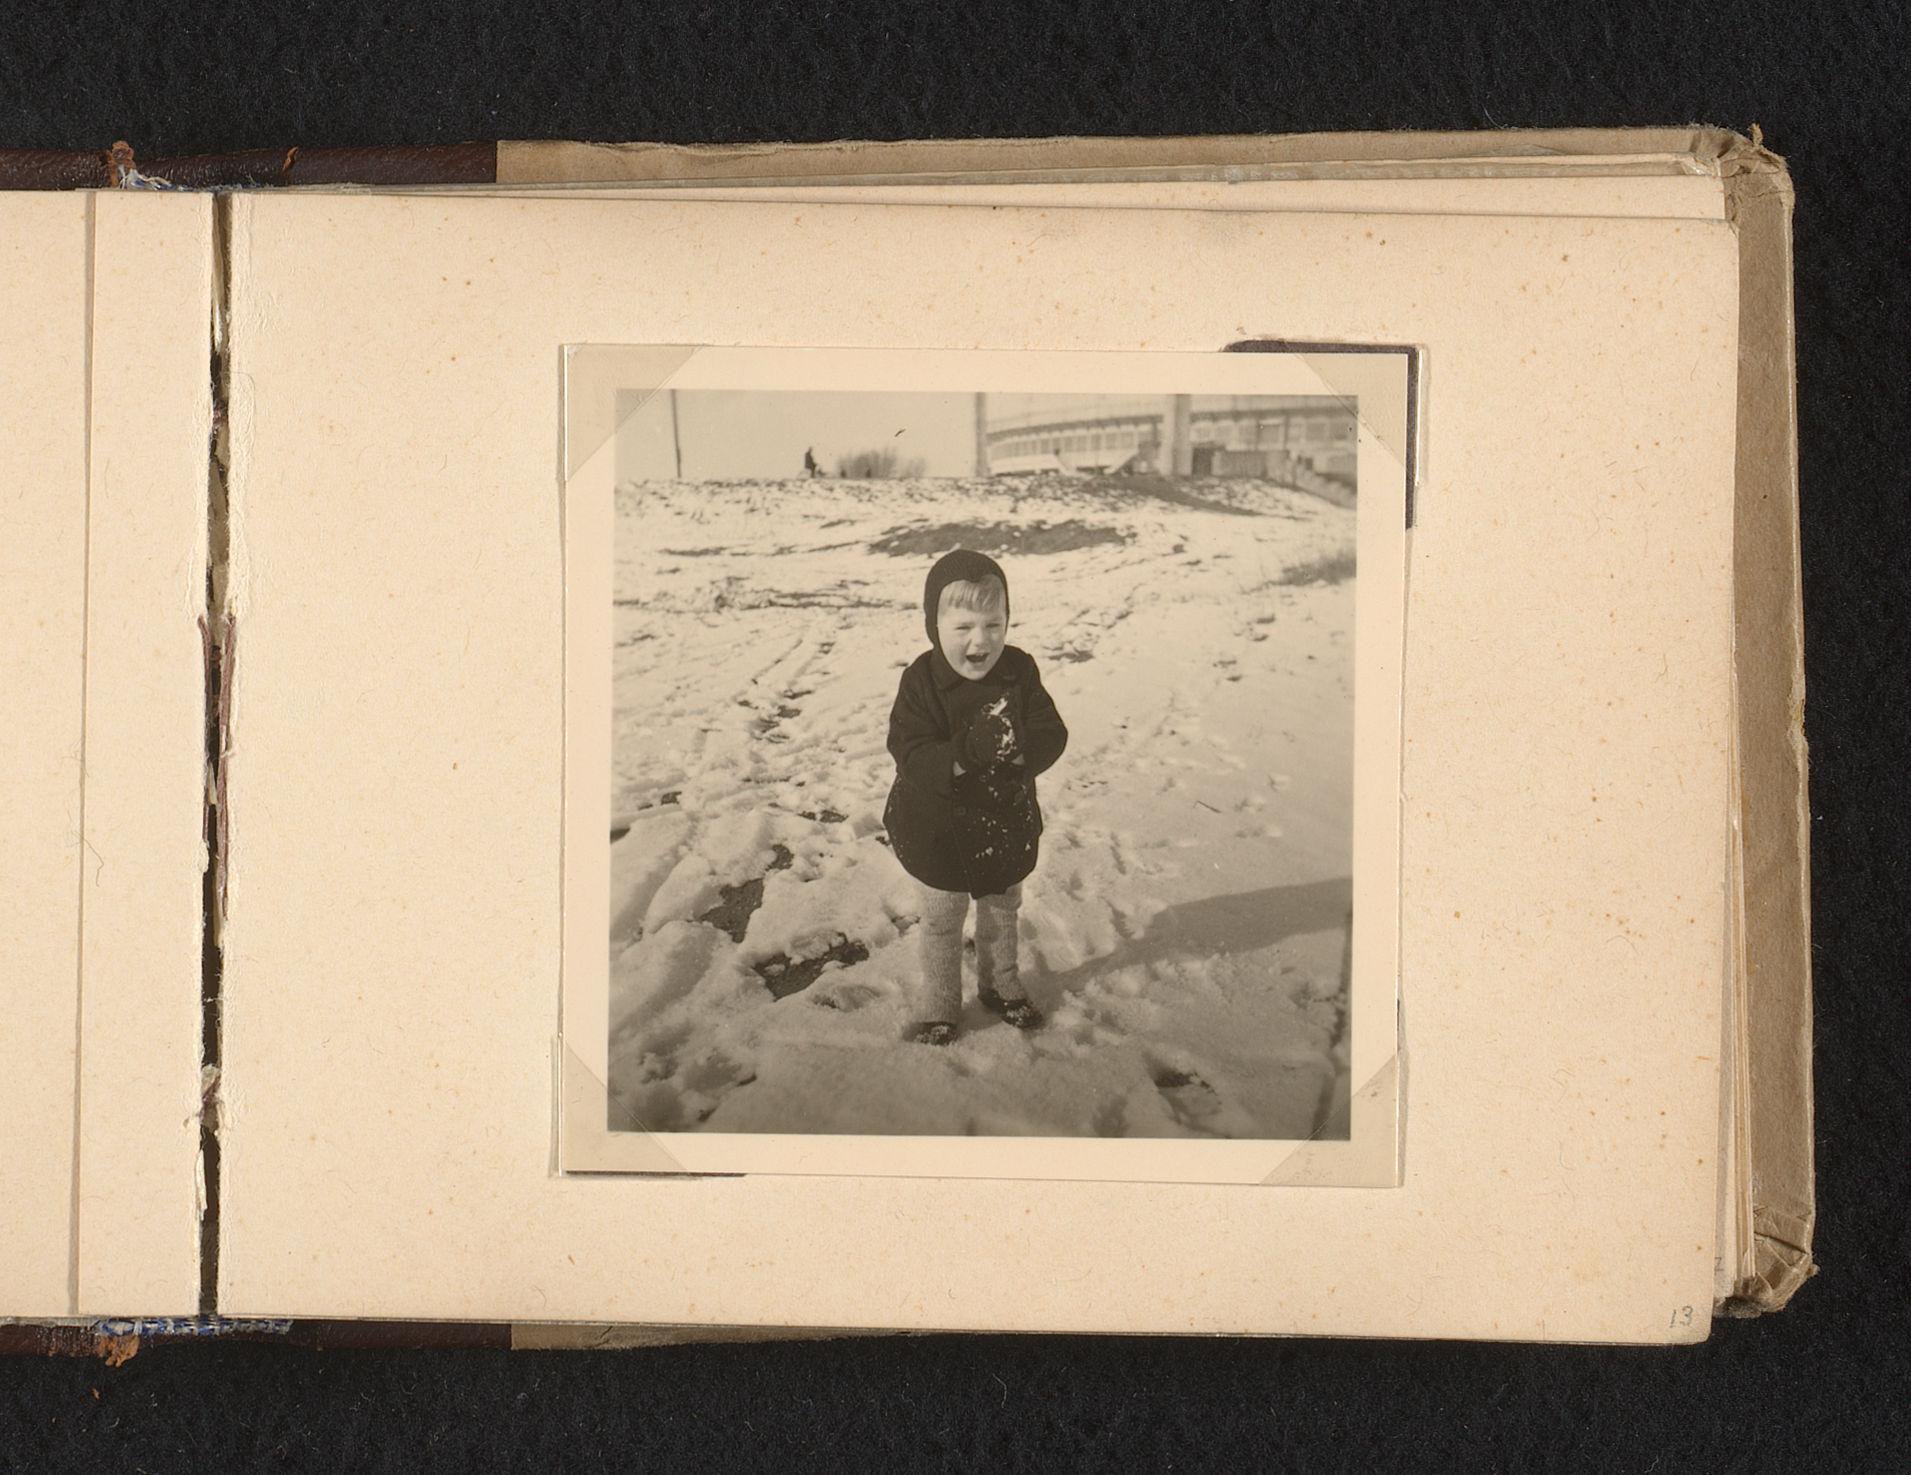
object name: album leaf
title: Norbert Peter van den Berg als peuter in de sneeuw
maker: norbert peter van den berg (1941-)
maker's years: 1941-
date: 1944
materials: paper, cardboard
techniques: gelatin silver print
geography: netherlands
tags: amsterdam, norbert peter van den berg (1941-), toddler, snow